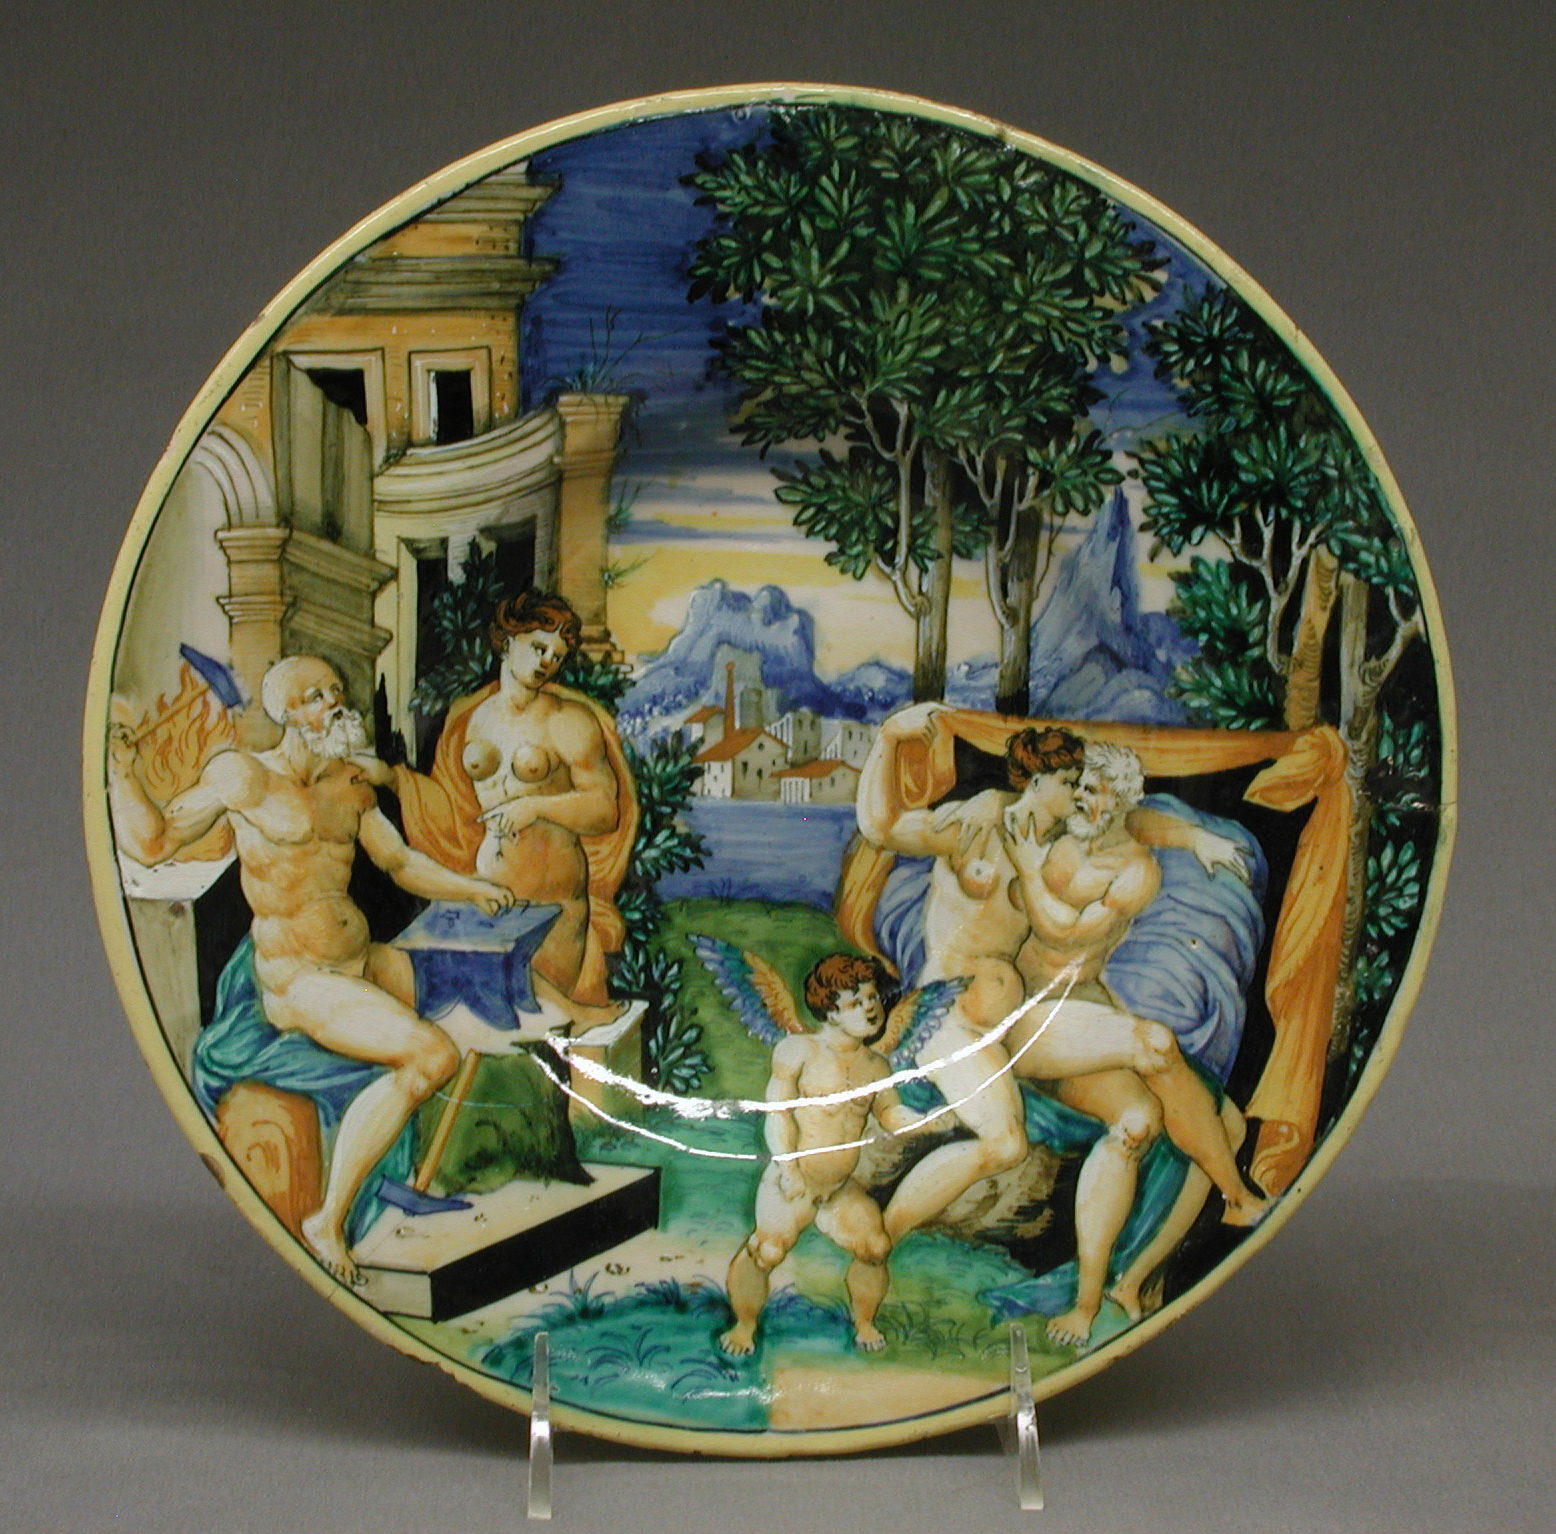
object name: plate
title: Plate depicting scene of Vulcan, Venus and Mars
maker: fra xanto avelli da rovigo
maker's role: artist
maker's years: 1486-1582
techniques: maiolica, glazing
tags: mars,venus,vulcan,trees